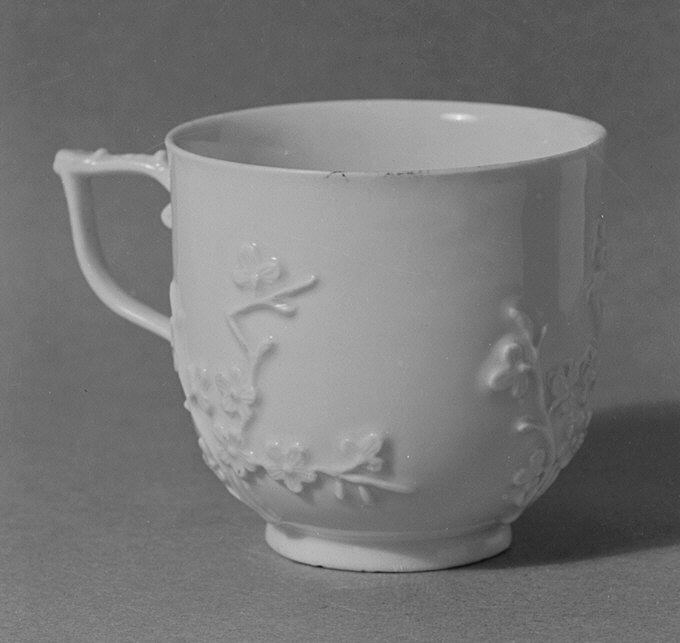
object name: cup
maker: meissen manufactory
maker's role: manufactory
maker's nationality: german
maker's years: 1710-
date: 1740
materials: hard paste porcelain